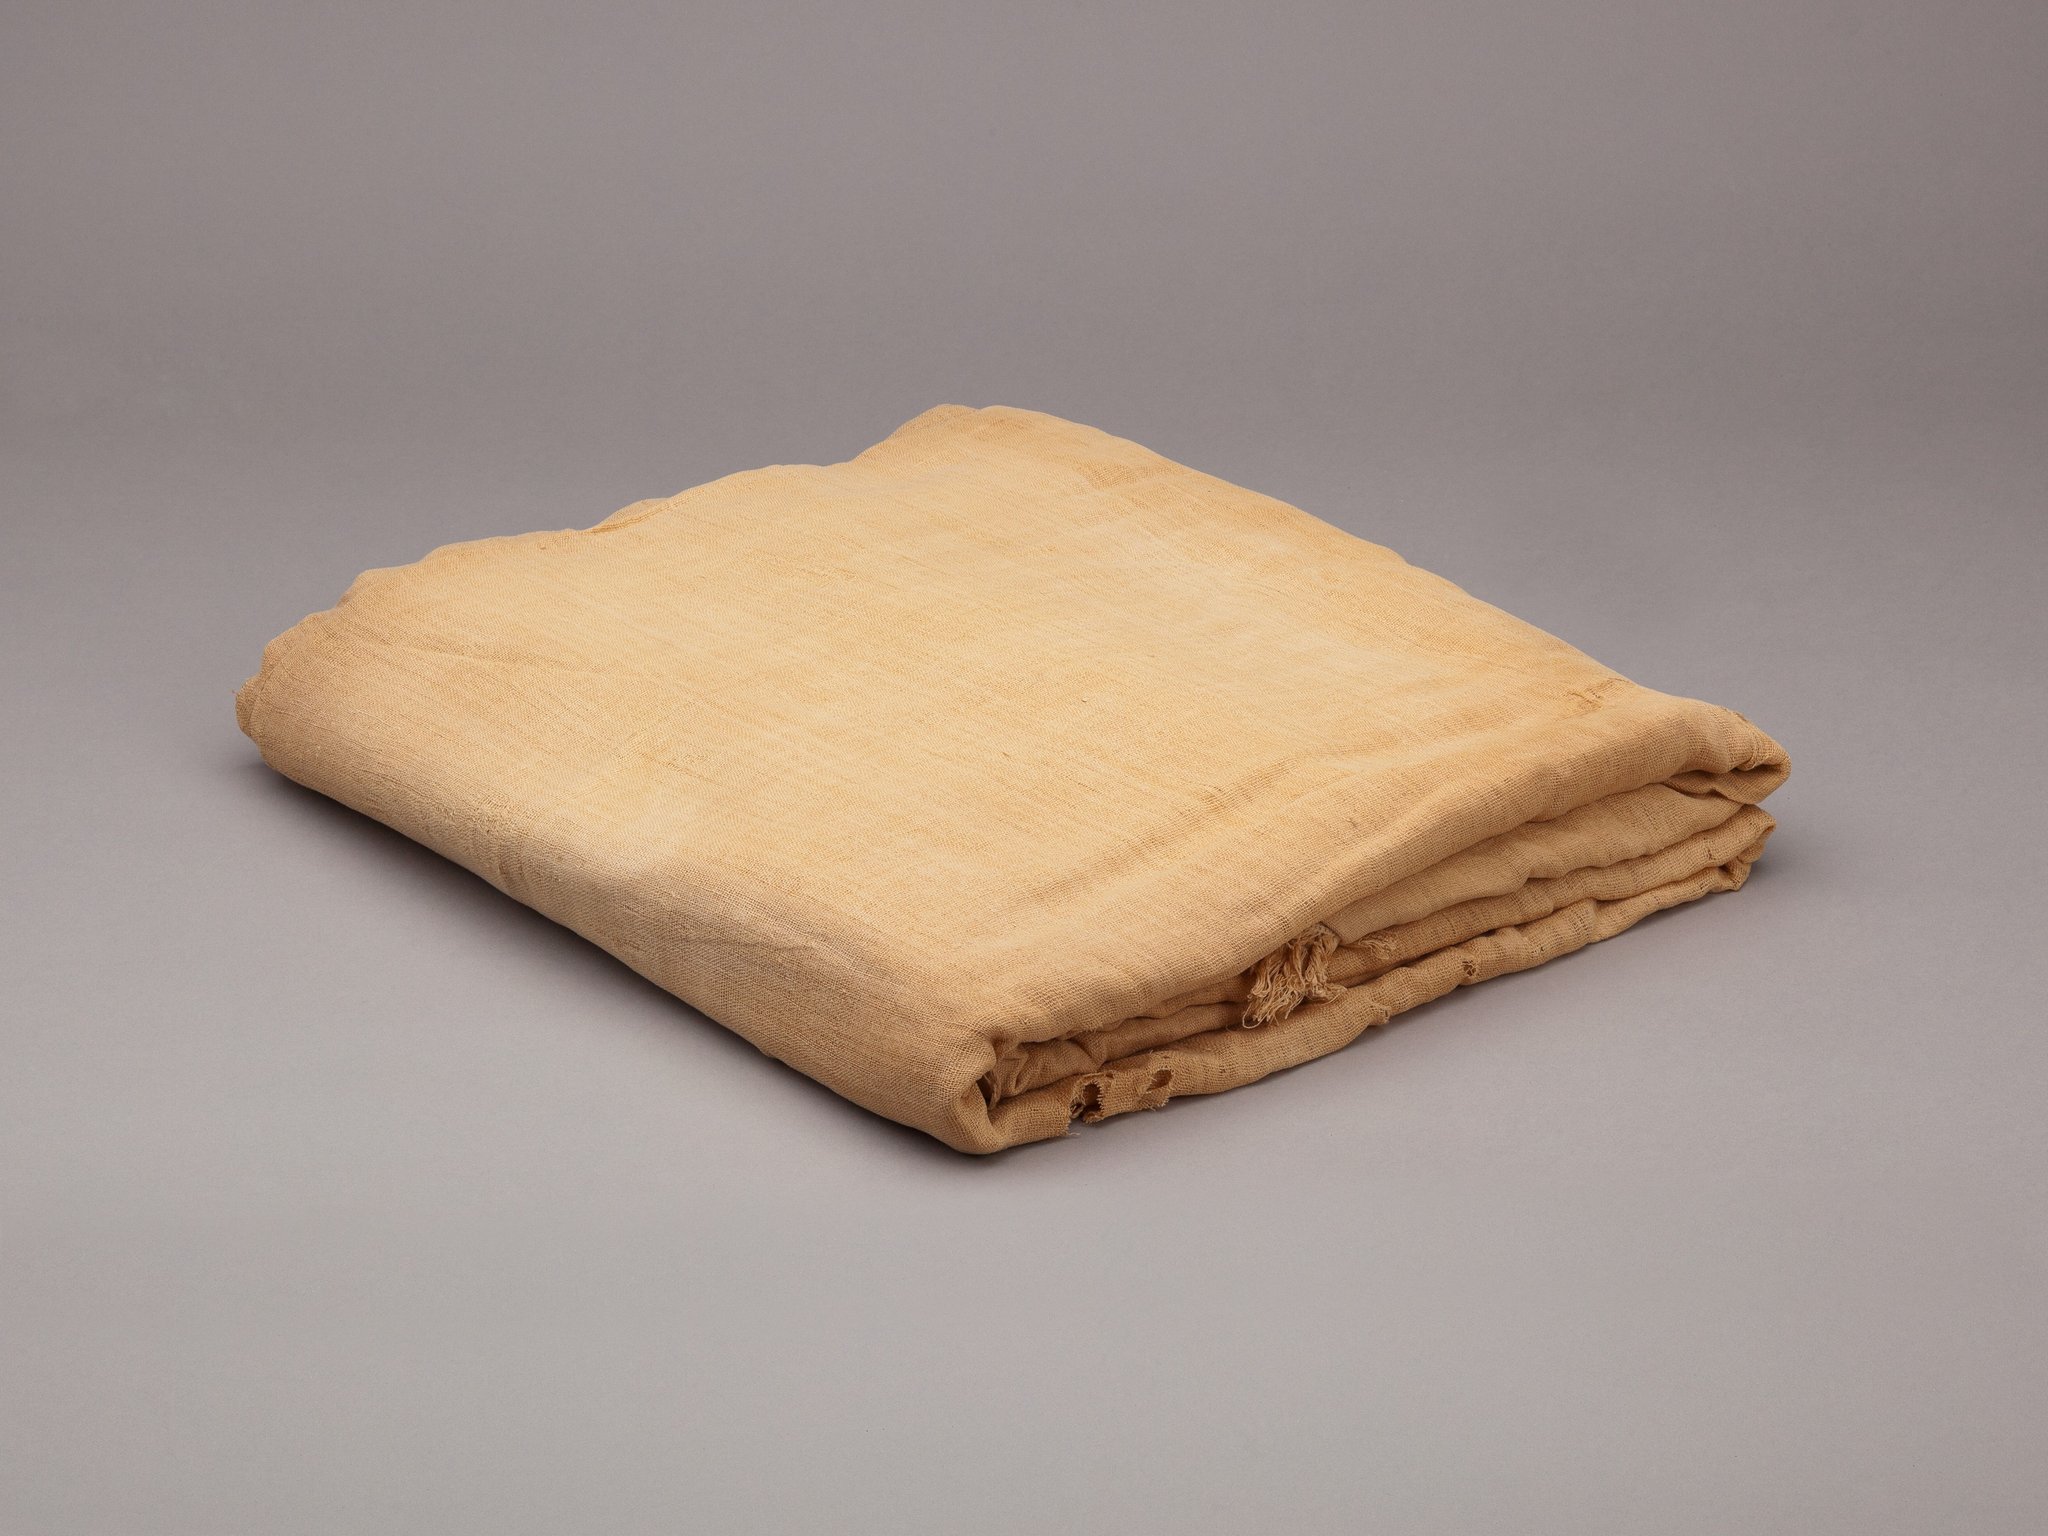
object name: linen mark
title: Sheet, linen mark, coarse spin, close weave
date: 1492-1473 BCE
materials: linen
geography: egypt